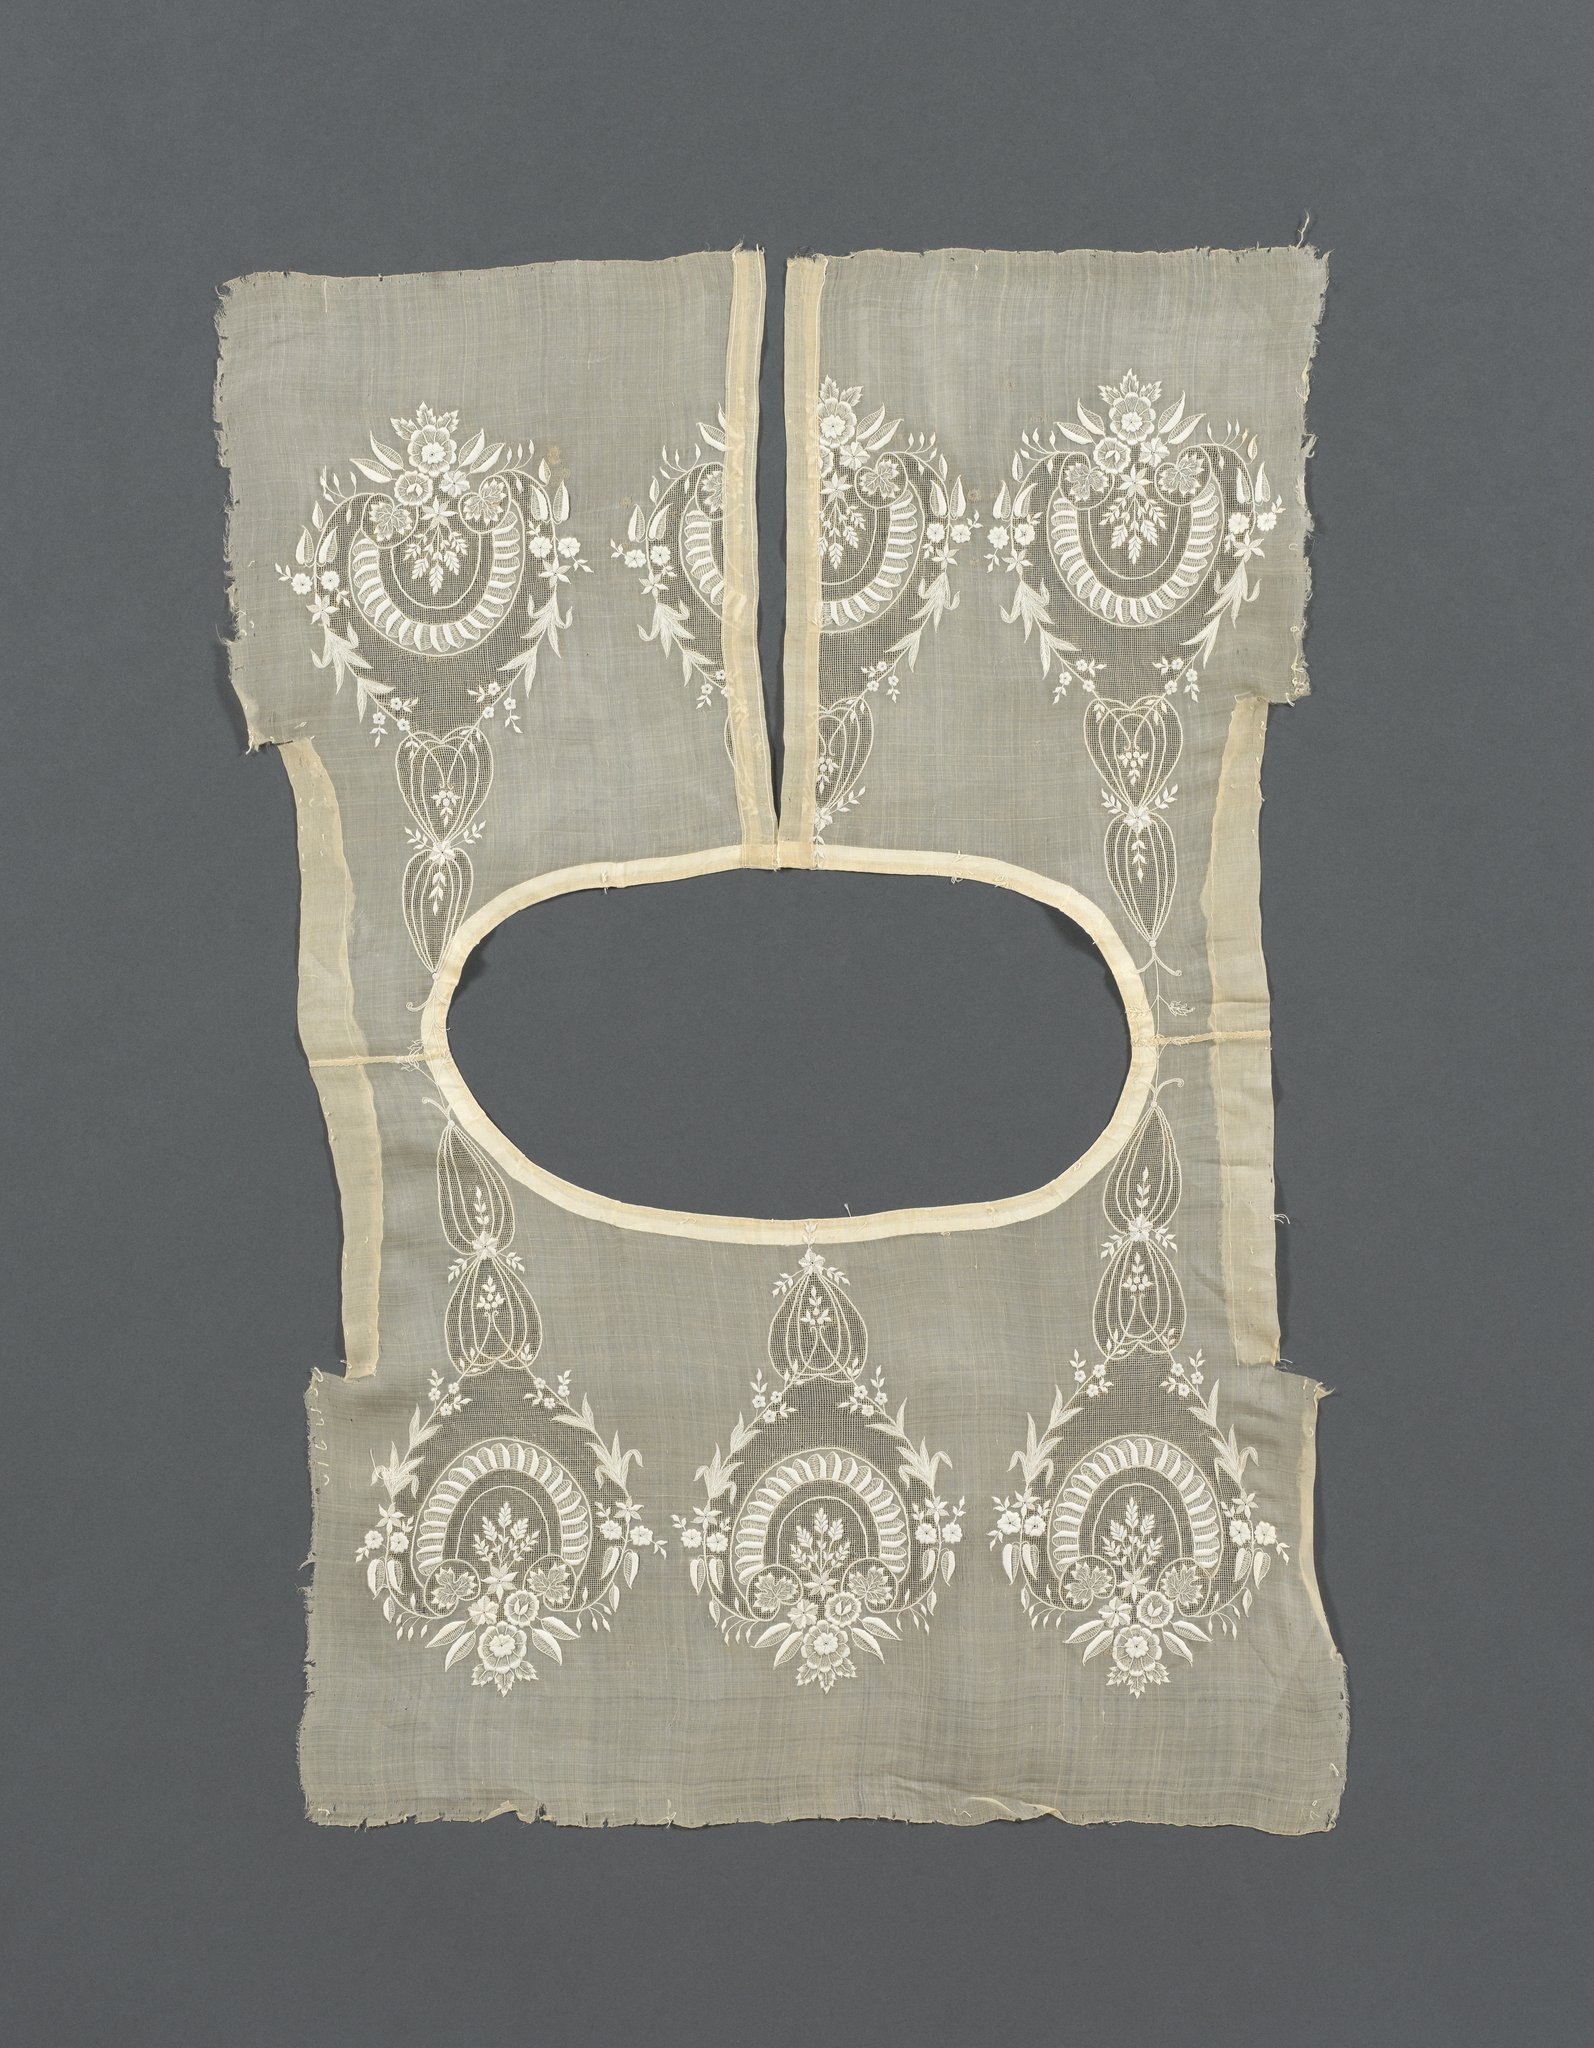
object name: waist and kerchief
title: Waist and kerchief (four pieces)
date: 1801-1900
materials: fiber